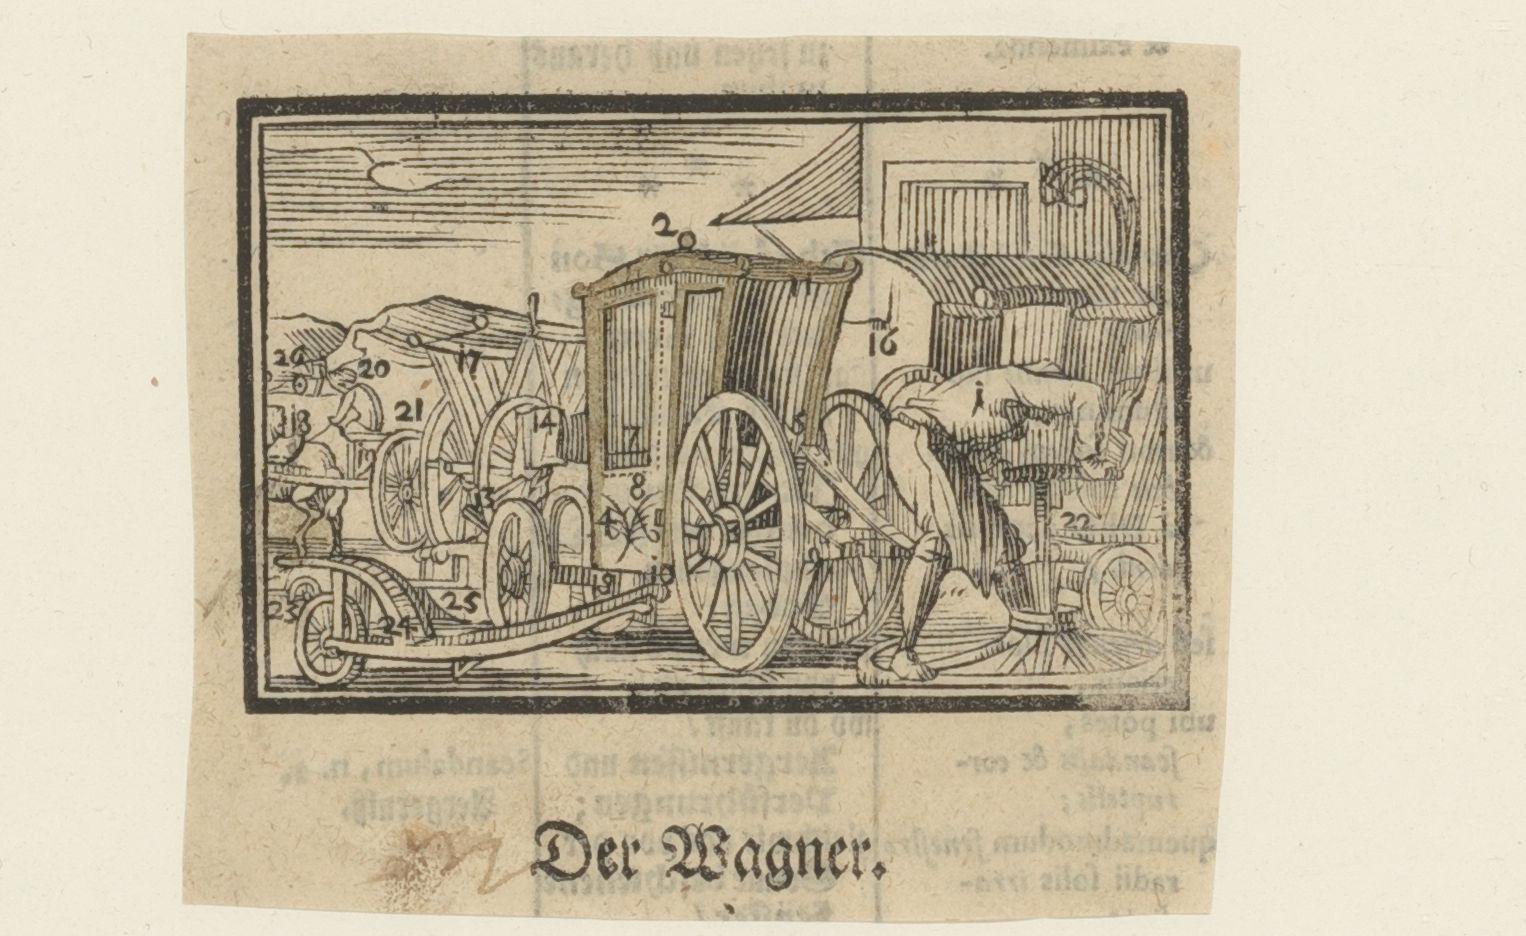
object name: print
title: Wagenmaker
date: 1719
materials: paper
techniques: hand coloring, letterpress printing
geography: nuremberg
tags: animal traction, animal-drawn vehicle (carriage etc.), wheel (of vehicle), handicrafts, craftsman at work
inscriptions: stamp, collector's mark: Lugt 1641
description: Prent uit: Comenius, Johannes Amosius. Orbis sensualium picti pars prima (...). Neurenberg: Martin Endter, 1719, dl. 2, p. 228. Prent eerder gebruikt in: Comenius, Johannes Amosius. Orbis Sensualium Picti denuo aucti Pars Secunda (...). Neurenberg: Martin Endter, 1730, dl. 2.